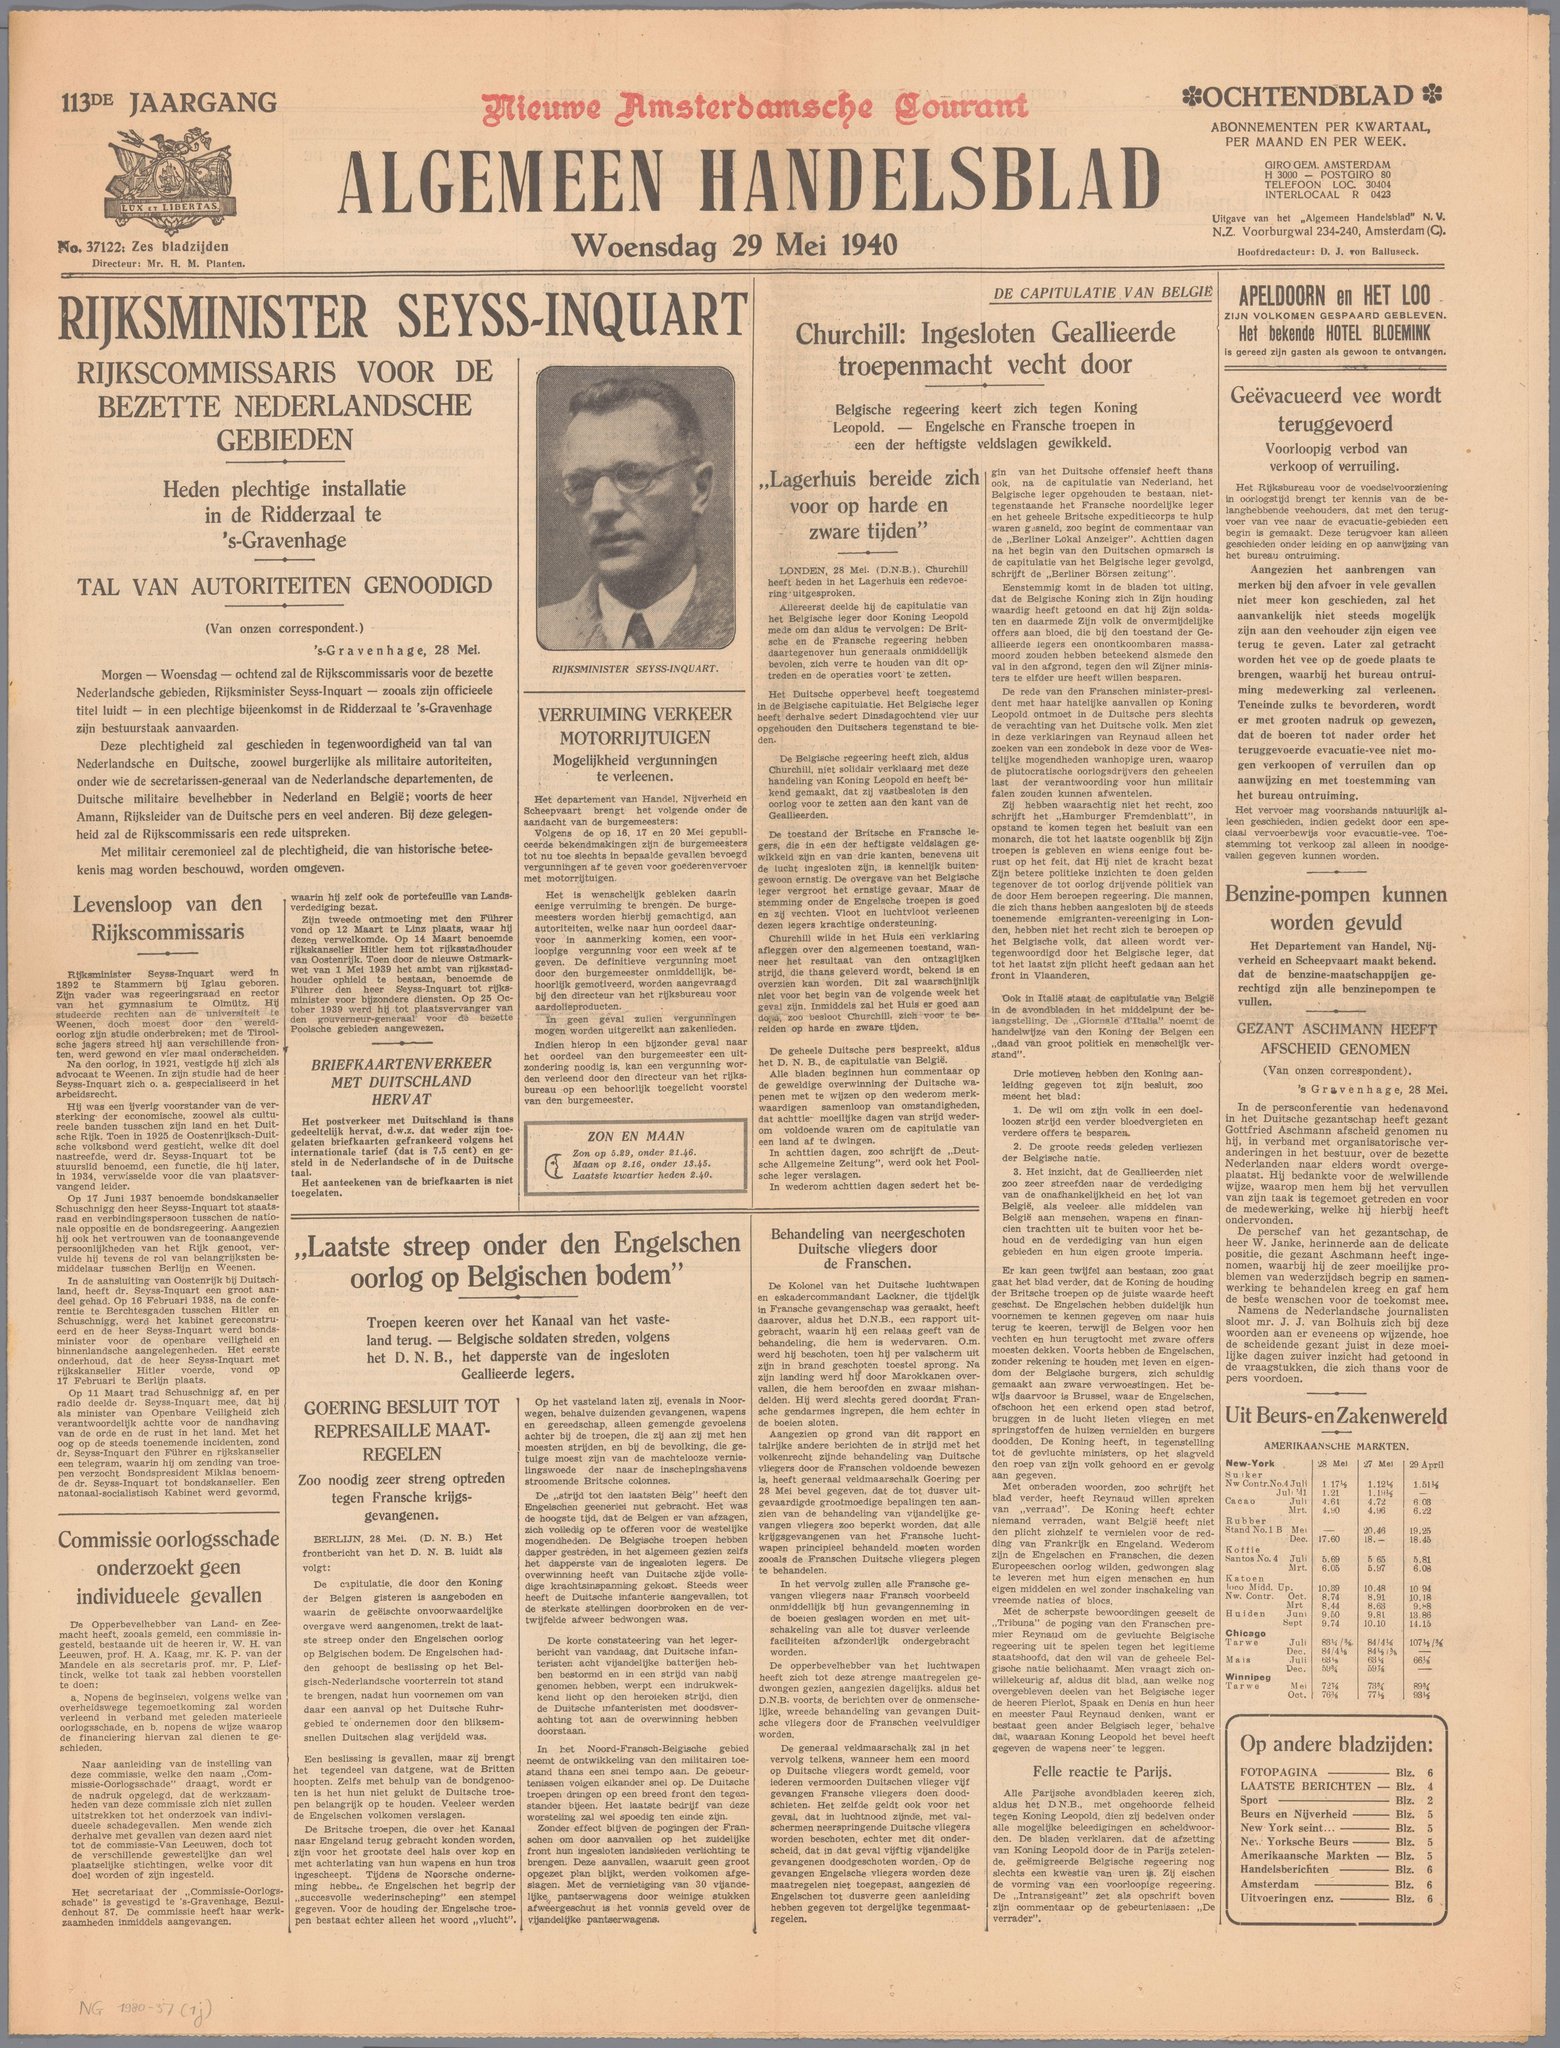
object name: newspaper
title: Algemeen Handelsblad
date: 1940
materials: paper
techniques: printing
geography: amsterdam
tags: netherlands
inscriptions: date